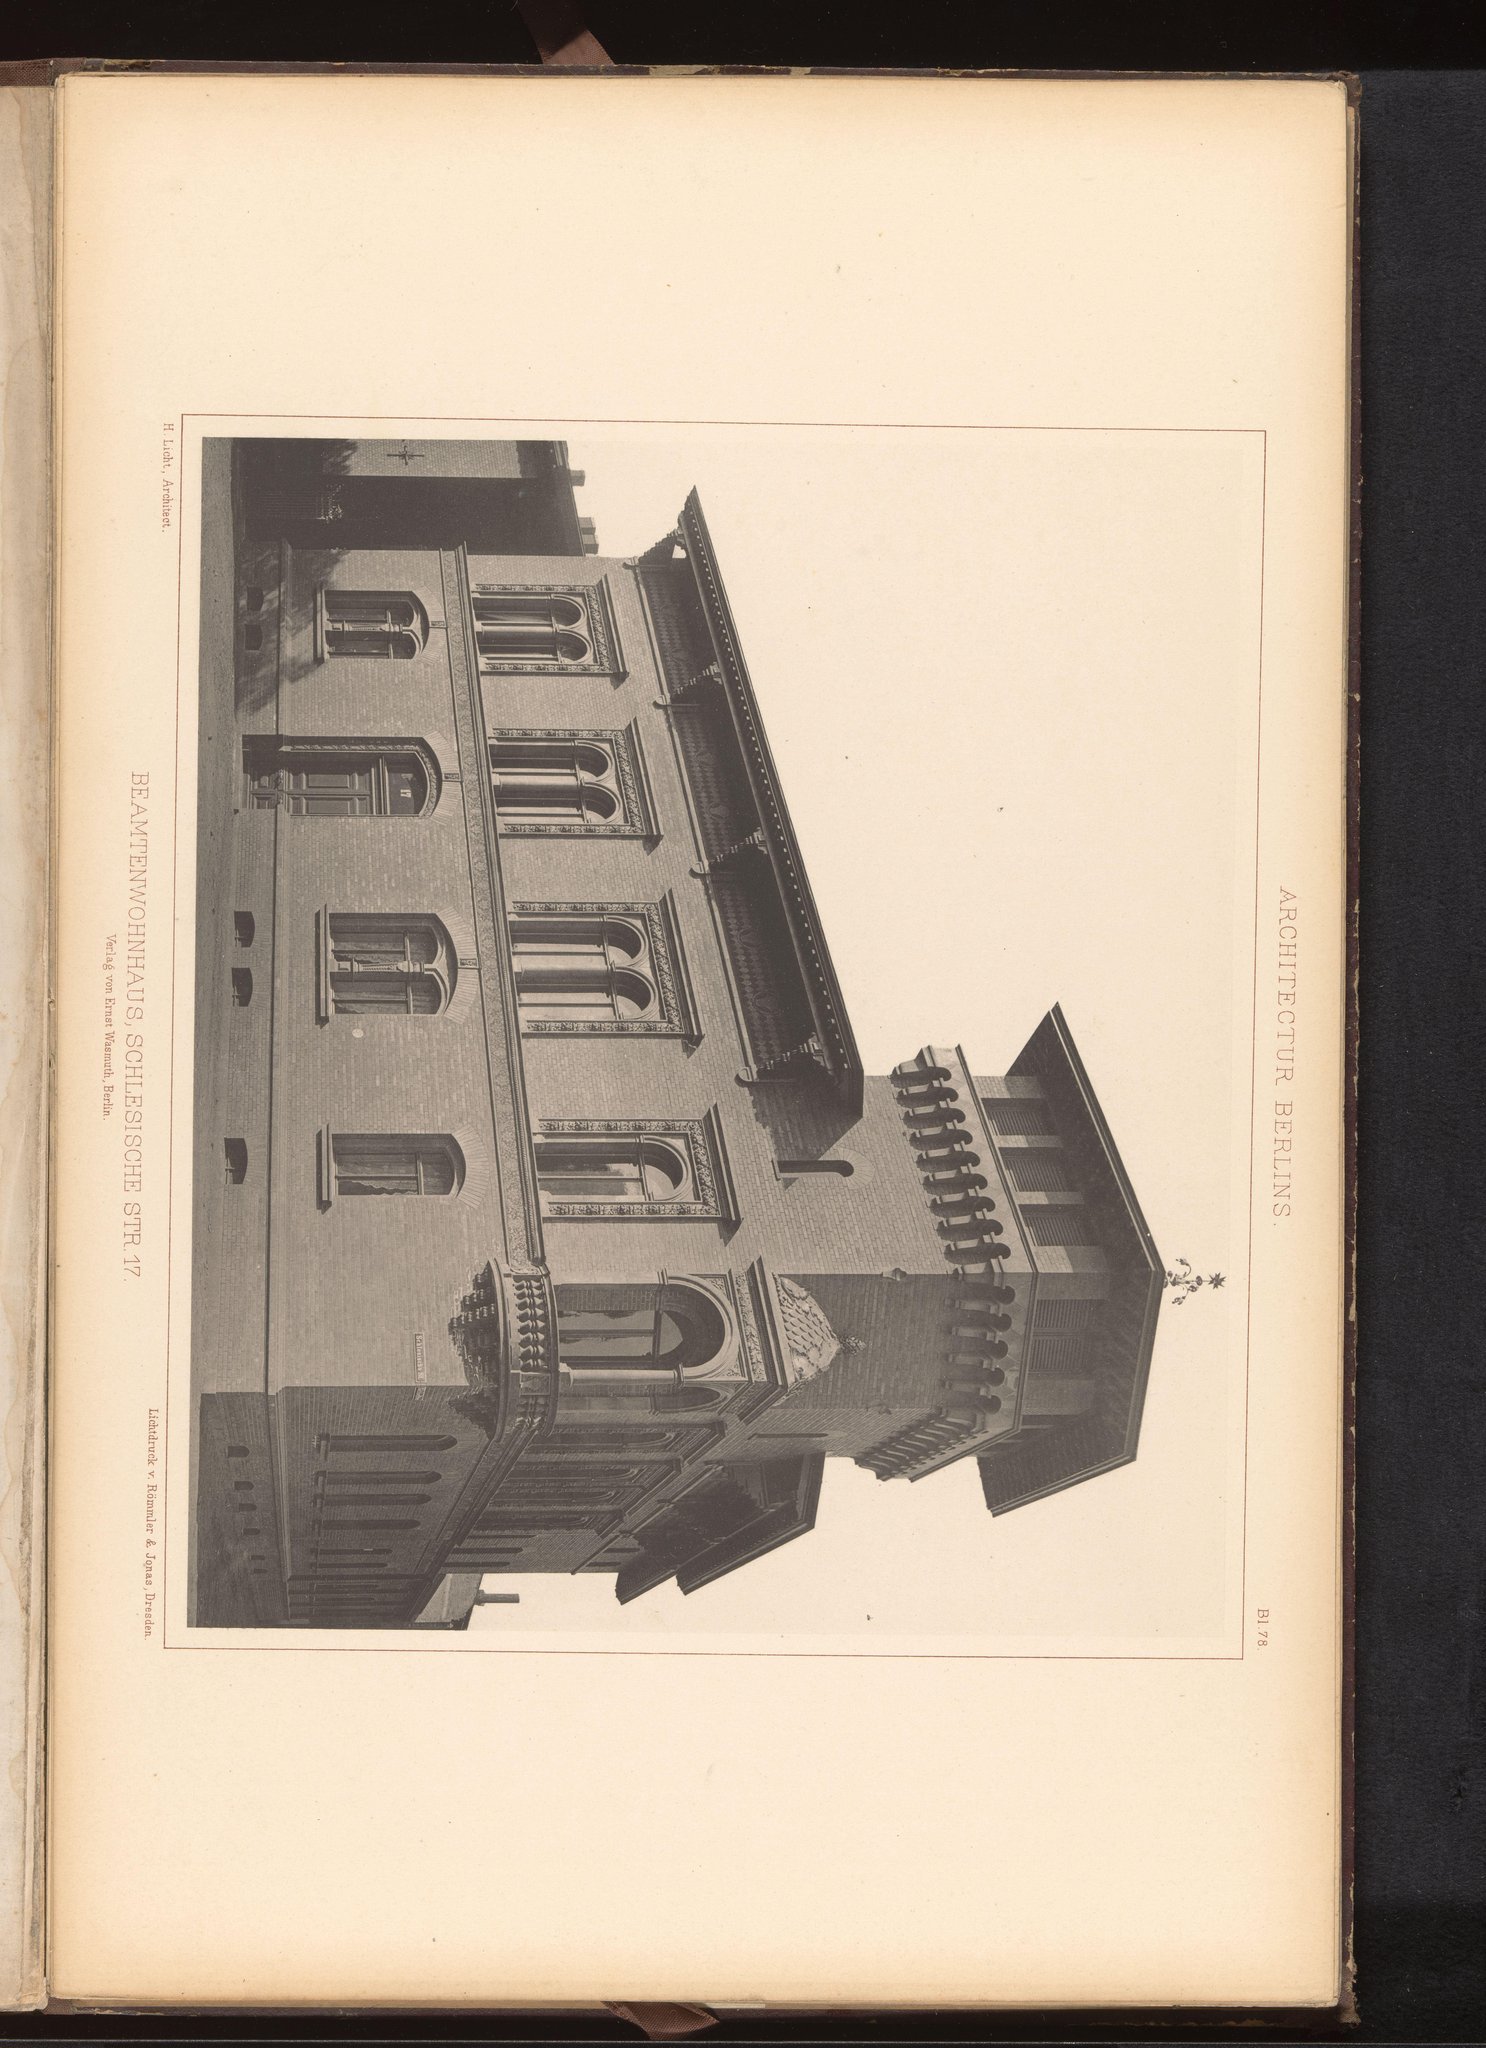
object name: photomechanical print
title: Beamtenwohnhaus, Schlesische Str. 17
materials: paper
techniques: photograph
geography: berlin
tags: detached house in city, berlin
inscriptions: number: ‘Bl. 78.’, inscription: ‘H. Licht, Architect.’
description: Deze prent maakt deel uit van een omslag met honderd prenten en zes tekstbladen.